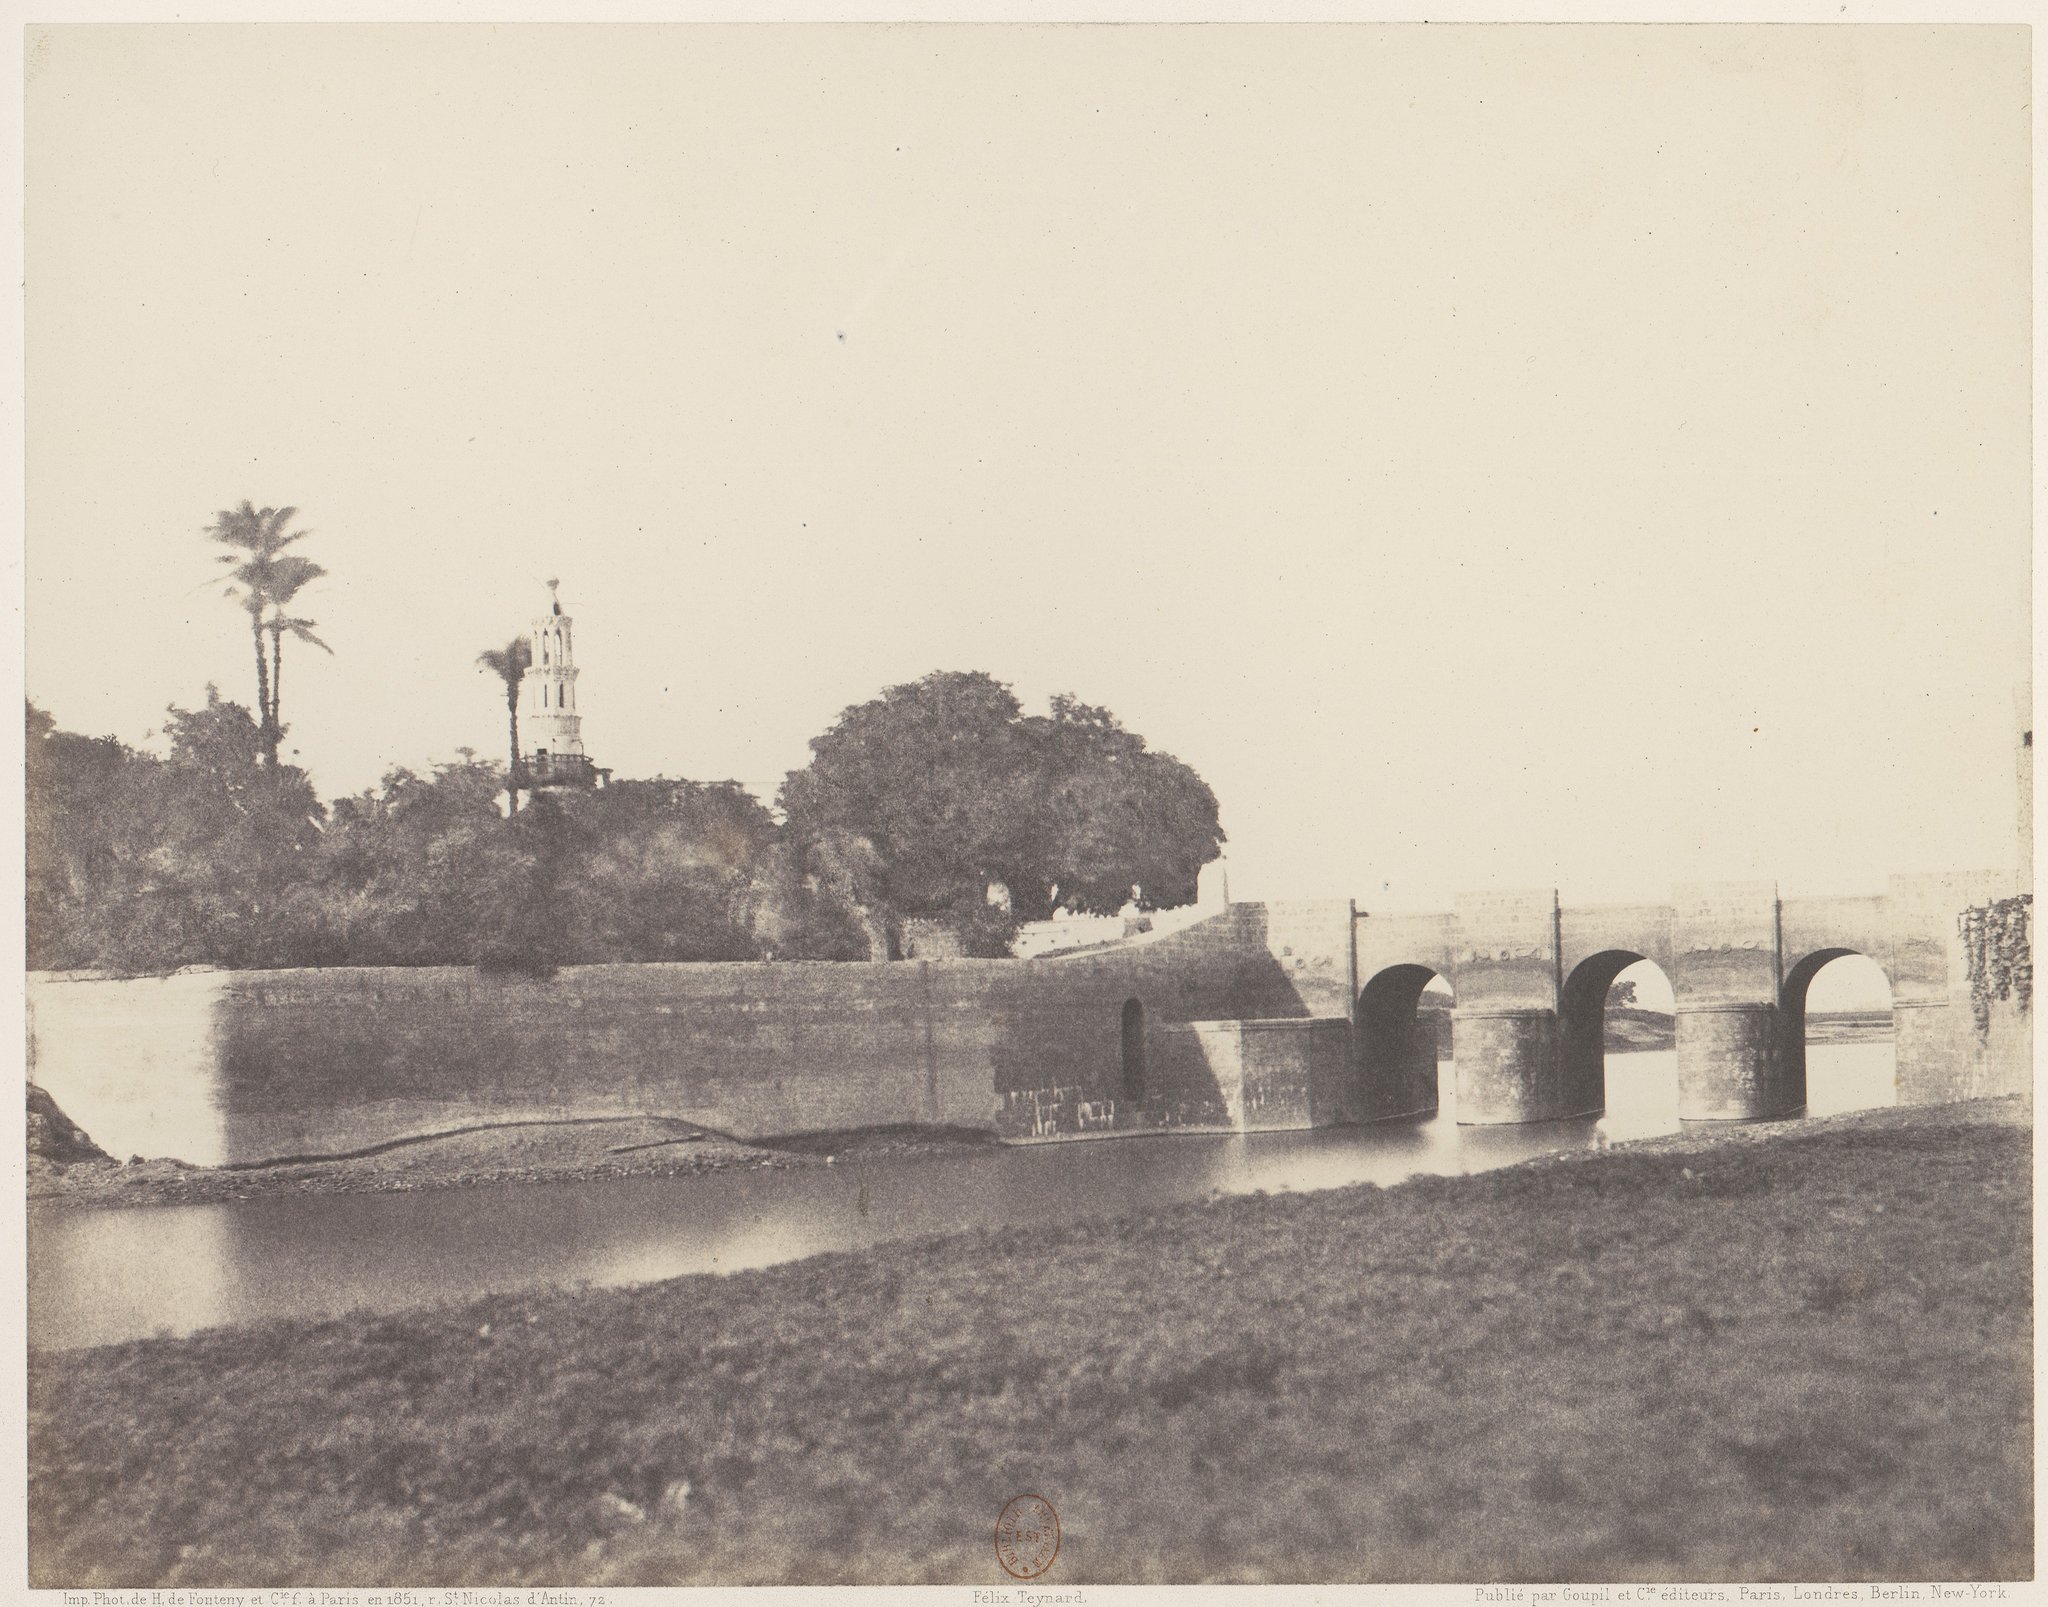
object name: photograph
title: Syout, Pont Sur le Grand Canal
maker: félix teynard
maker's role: artist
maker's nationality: french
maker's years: 1817-1892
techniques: paper negative, salted paper print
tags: bridges,canals